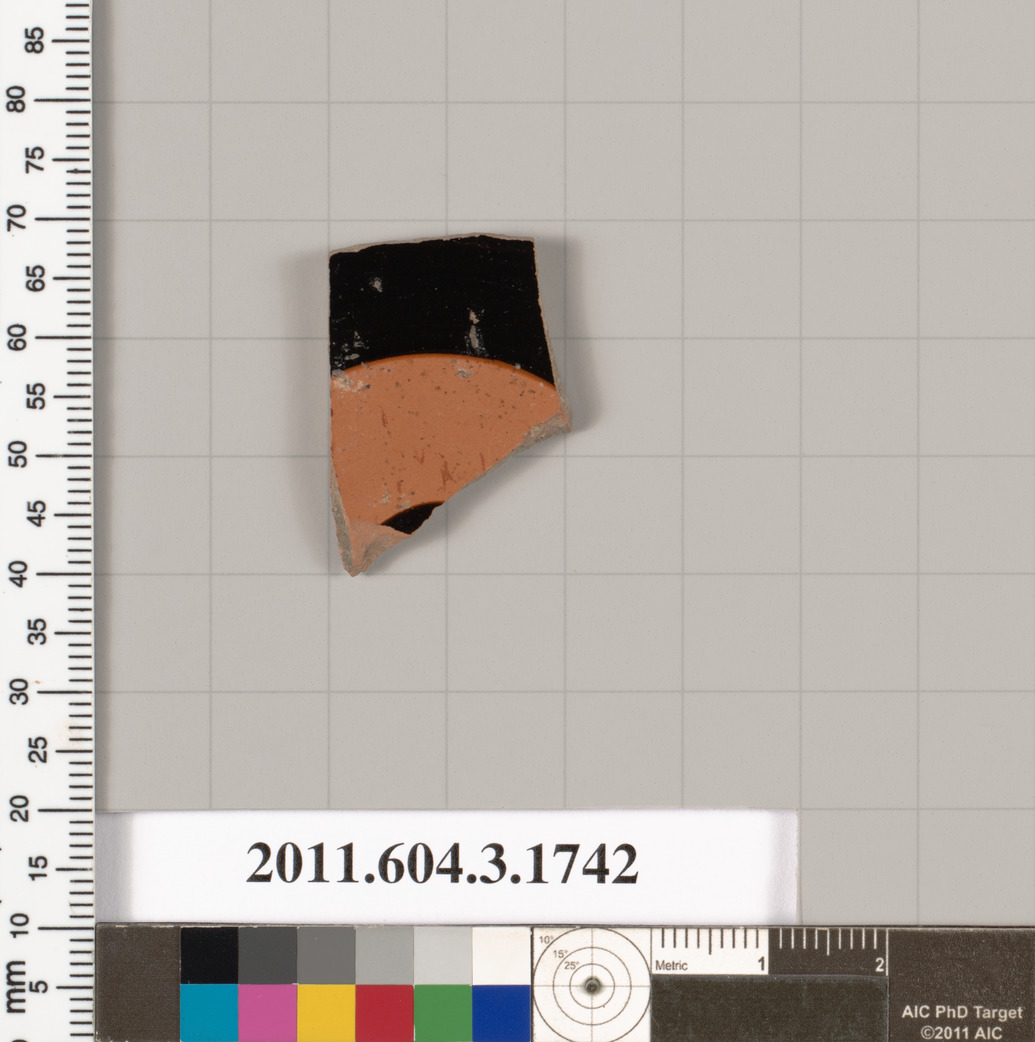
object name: kylix fragment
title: Terracotta fragment of a kylix: Band or lip cup (drinking cup)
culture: greek, attic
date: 550-526 BCE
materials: terracotta